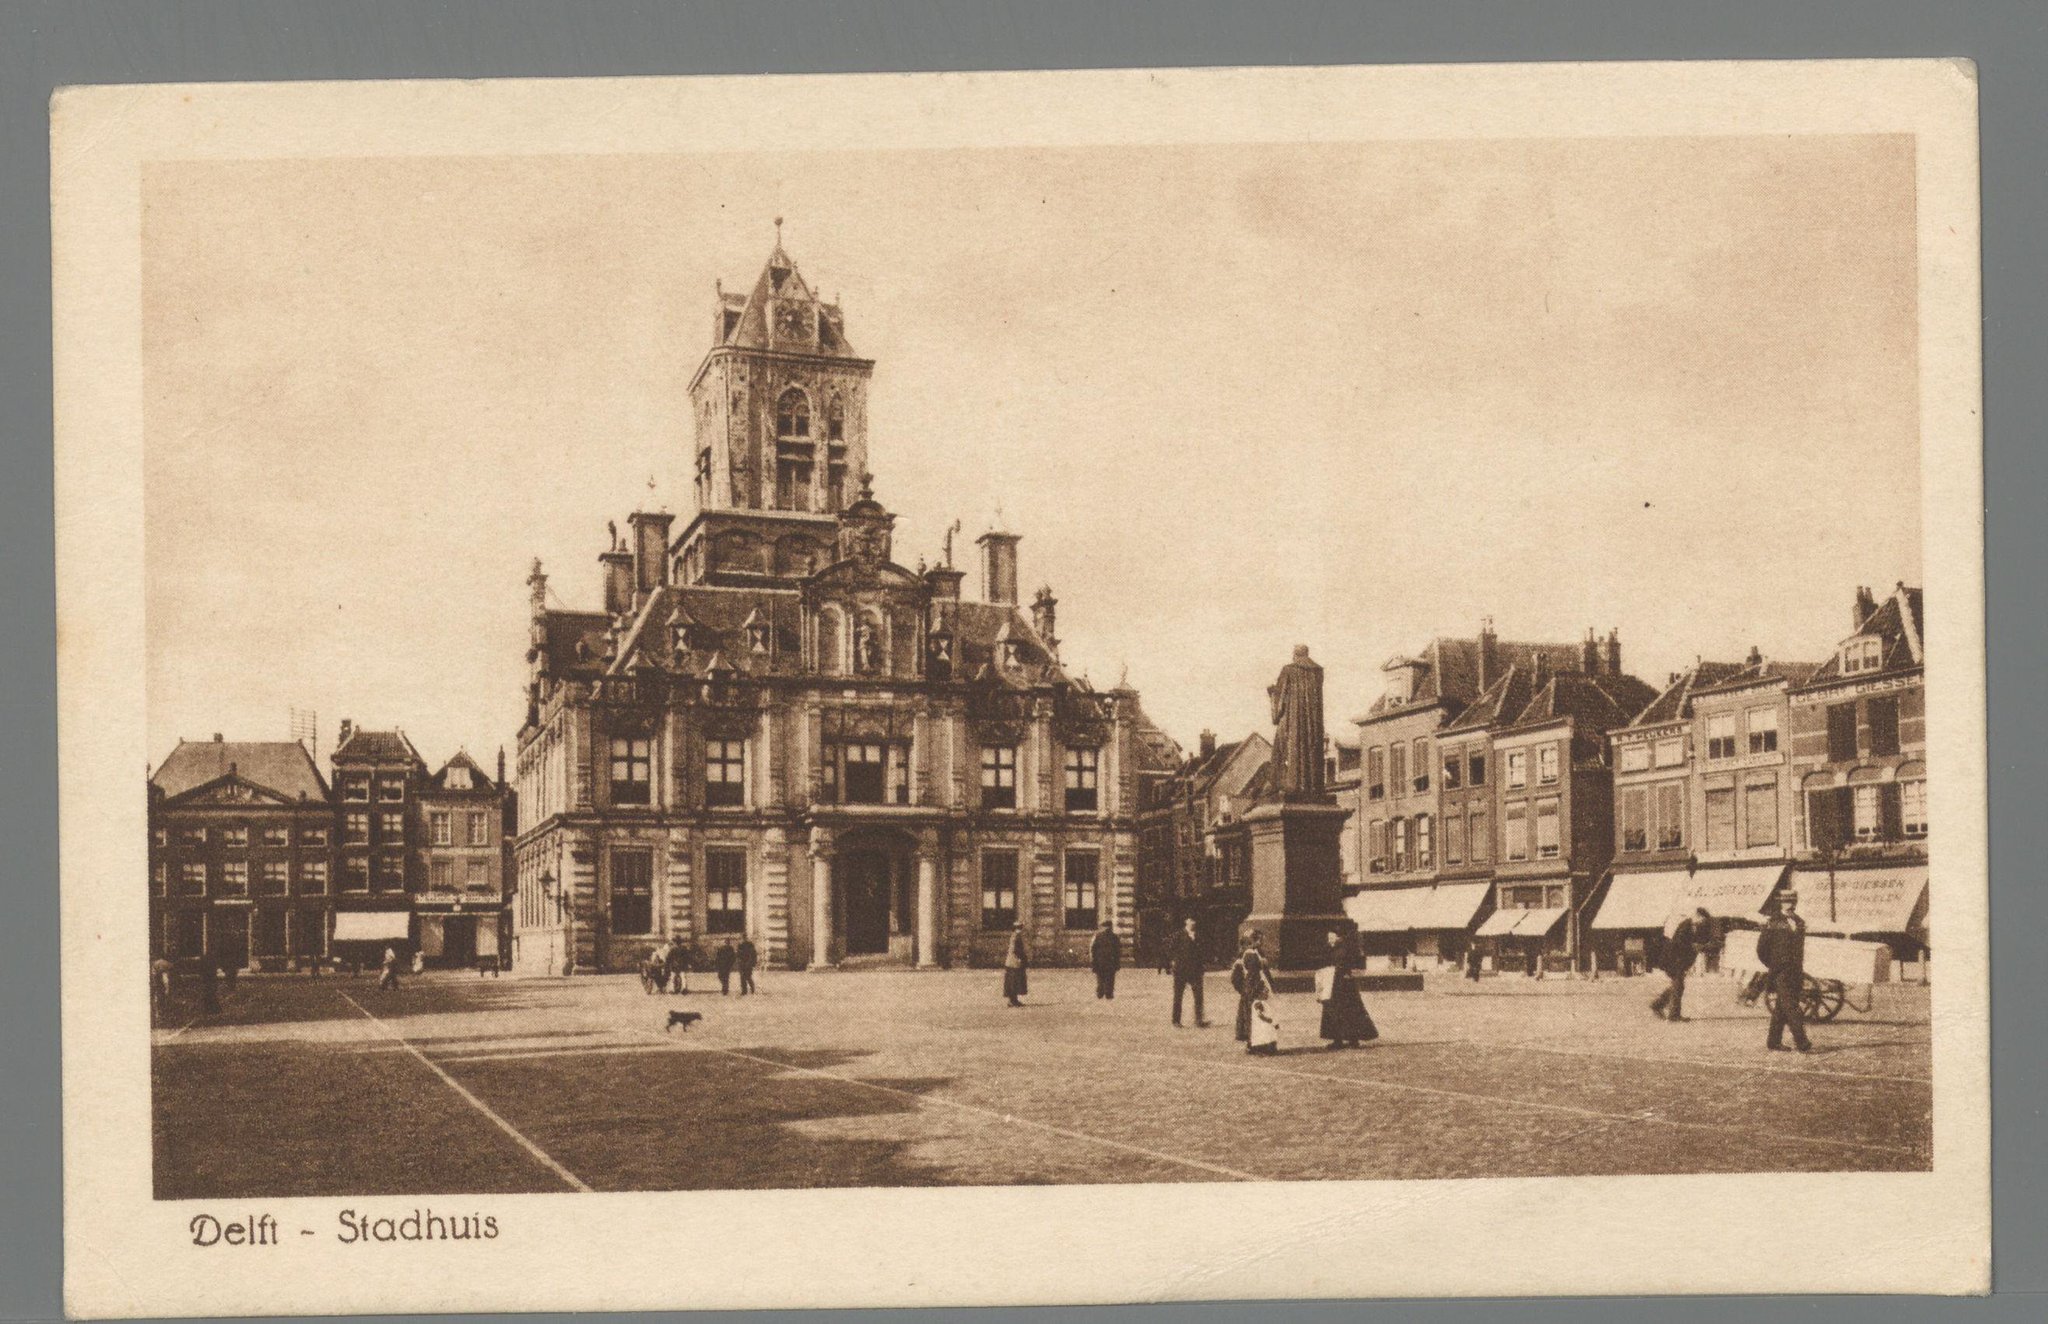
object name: ansichtkaart, prentbriefkaart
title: Delft - Stadhuis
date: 1919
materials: cardboard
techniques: rotogravure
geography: delft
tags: delft, hugo de groot, townhall, monument, statue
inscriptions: date